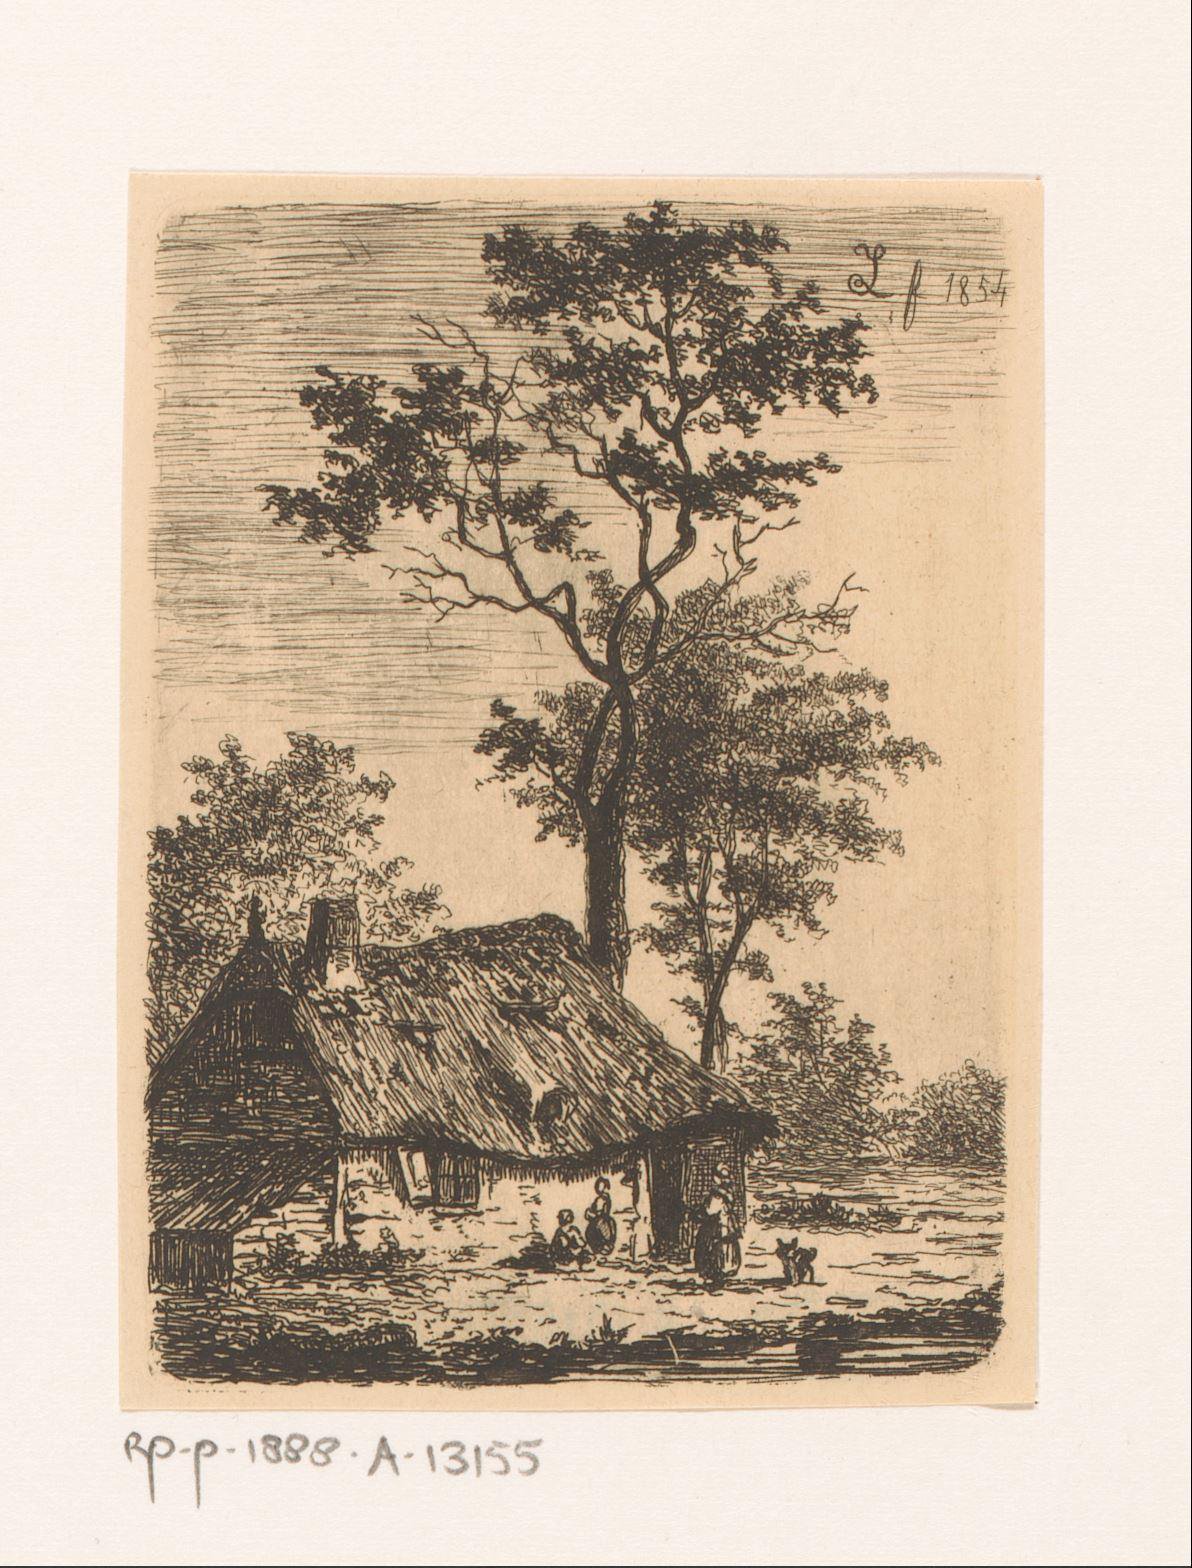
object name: print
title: Landschap met boerderij bij Oosterhout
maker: jean théodore joseph linnig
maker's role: draughtsman, print maker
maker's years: 1815-1891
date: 1854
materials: paper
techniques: etching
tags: farm or solitary house in landscape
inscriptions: collector's mark: Lugt 2228